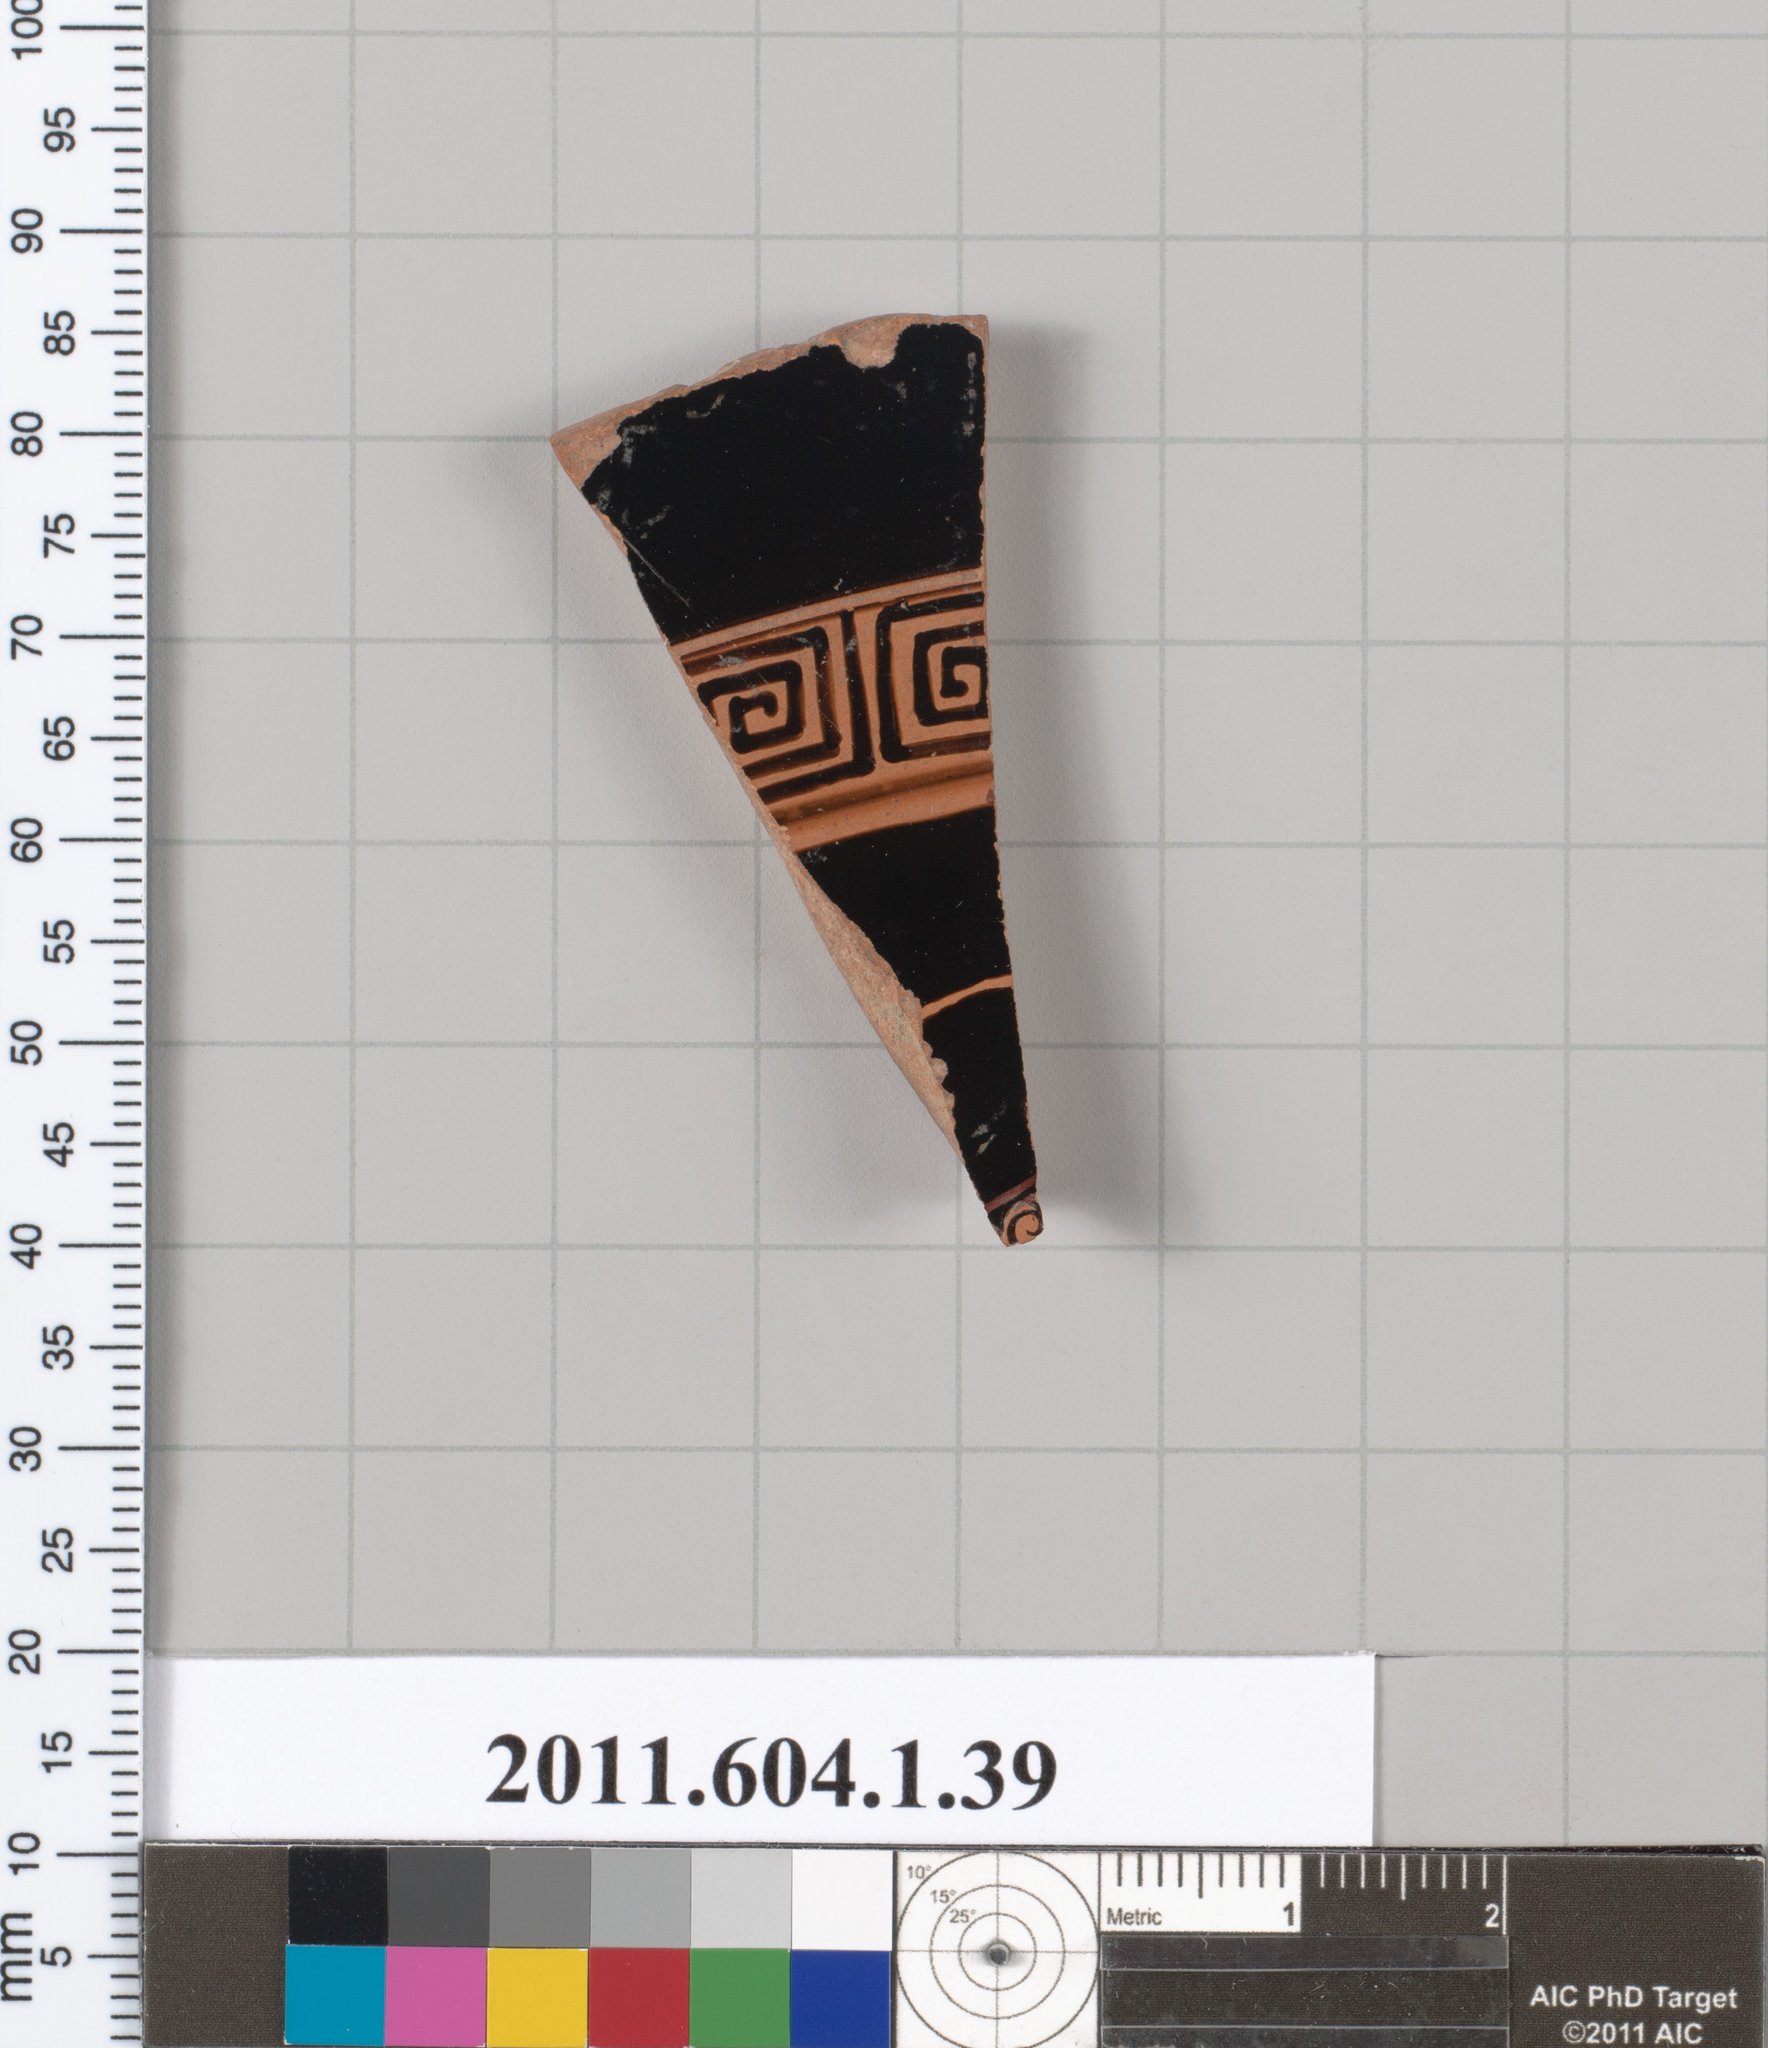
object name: kylix fragment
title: Terracotta fragment of a kylix (drinking cup)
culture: greek, attic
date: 490-480 BCE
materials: terracotta